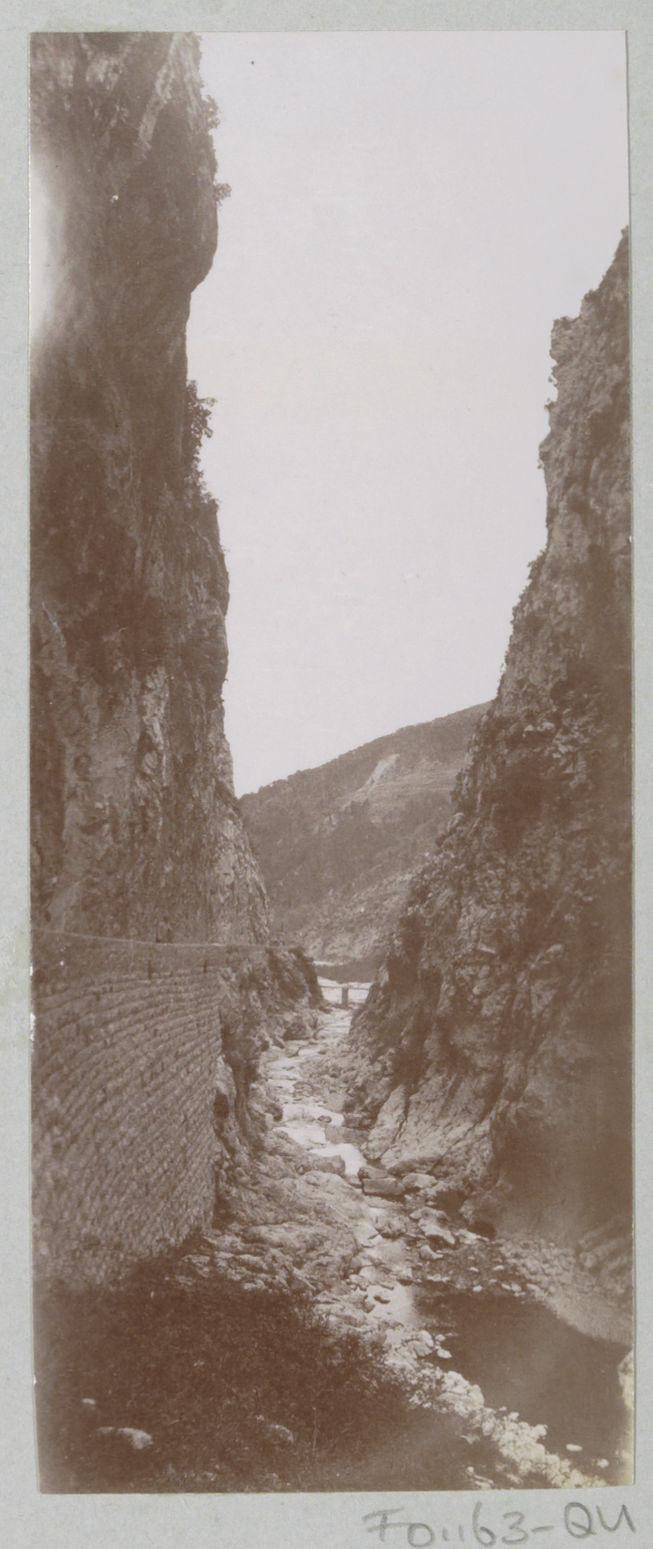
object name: photograph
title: Kloof, vermoedelijk bij L'Escarène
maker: delizy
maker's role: manufacturer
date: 1903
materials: paper, photographic support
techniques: gelatin silver print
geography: l'escarène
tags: ravine, chasm, abyss, canyon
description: Onderdeel van Fotoalbum van een Franse amateurfotograaf met opnames van uitstapjes in Frankrijk, Spanje, België, Luxemburg en Nederland, de eerste automobielen en autoraces.